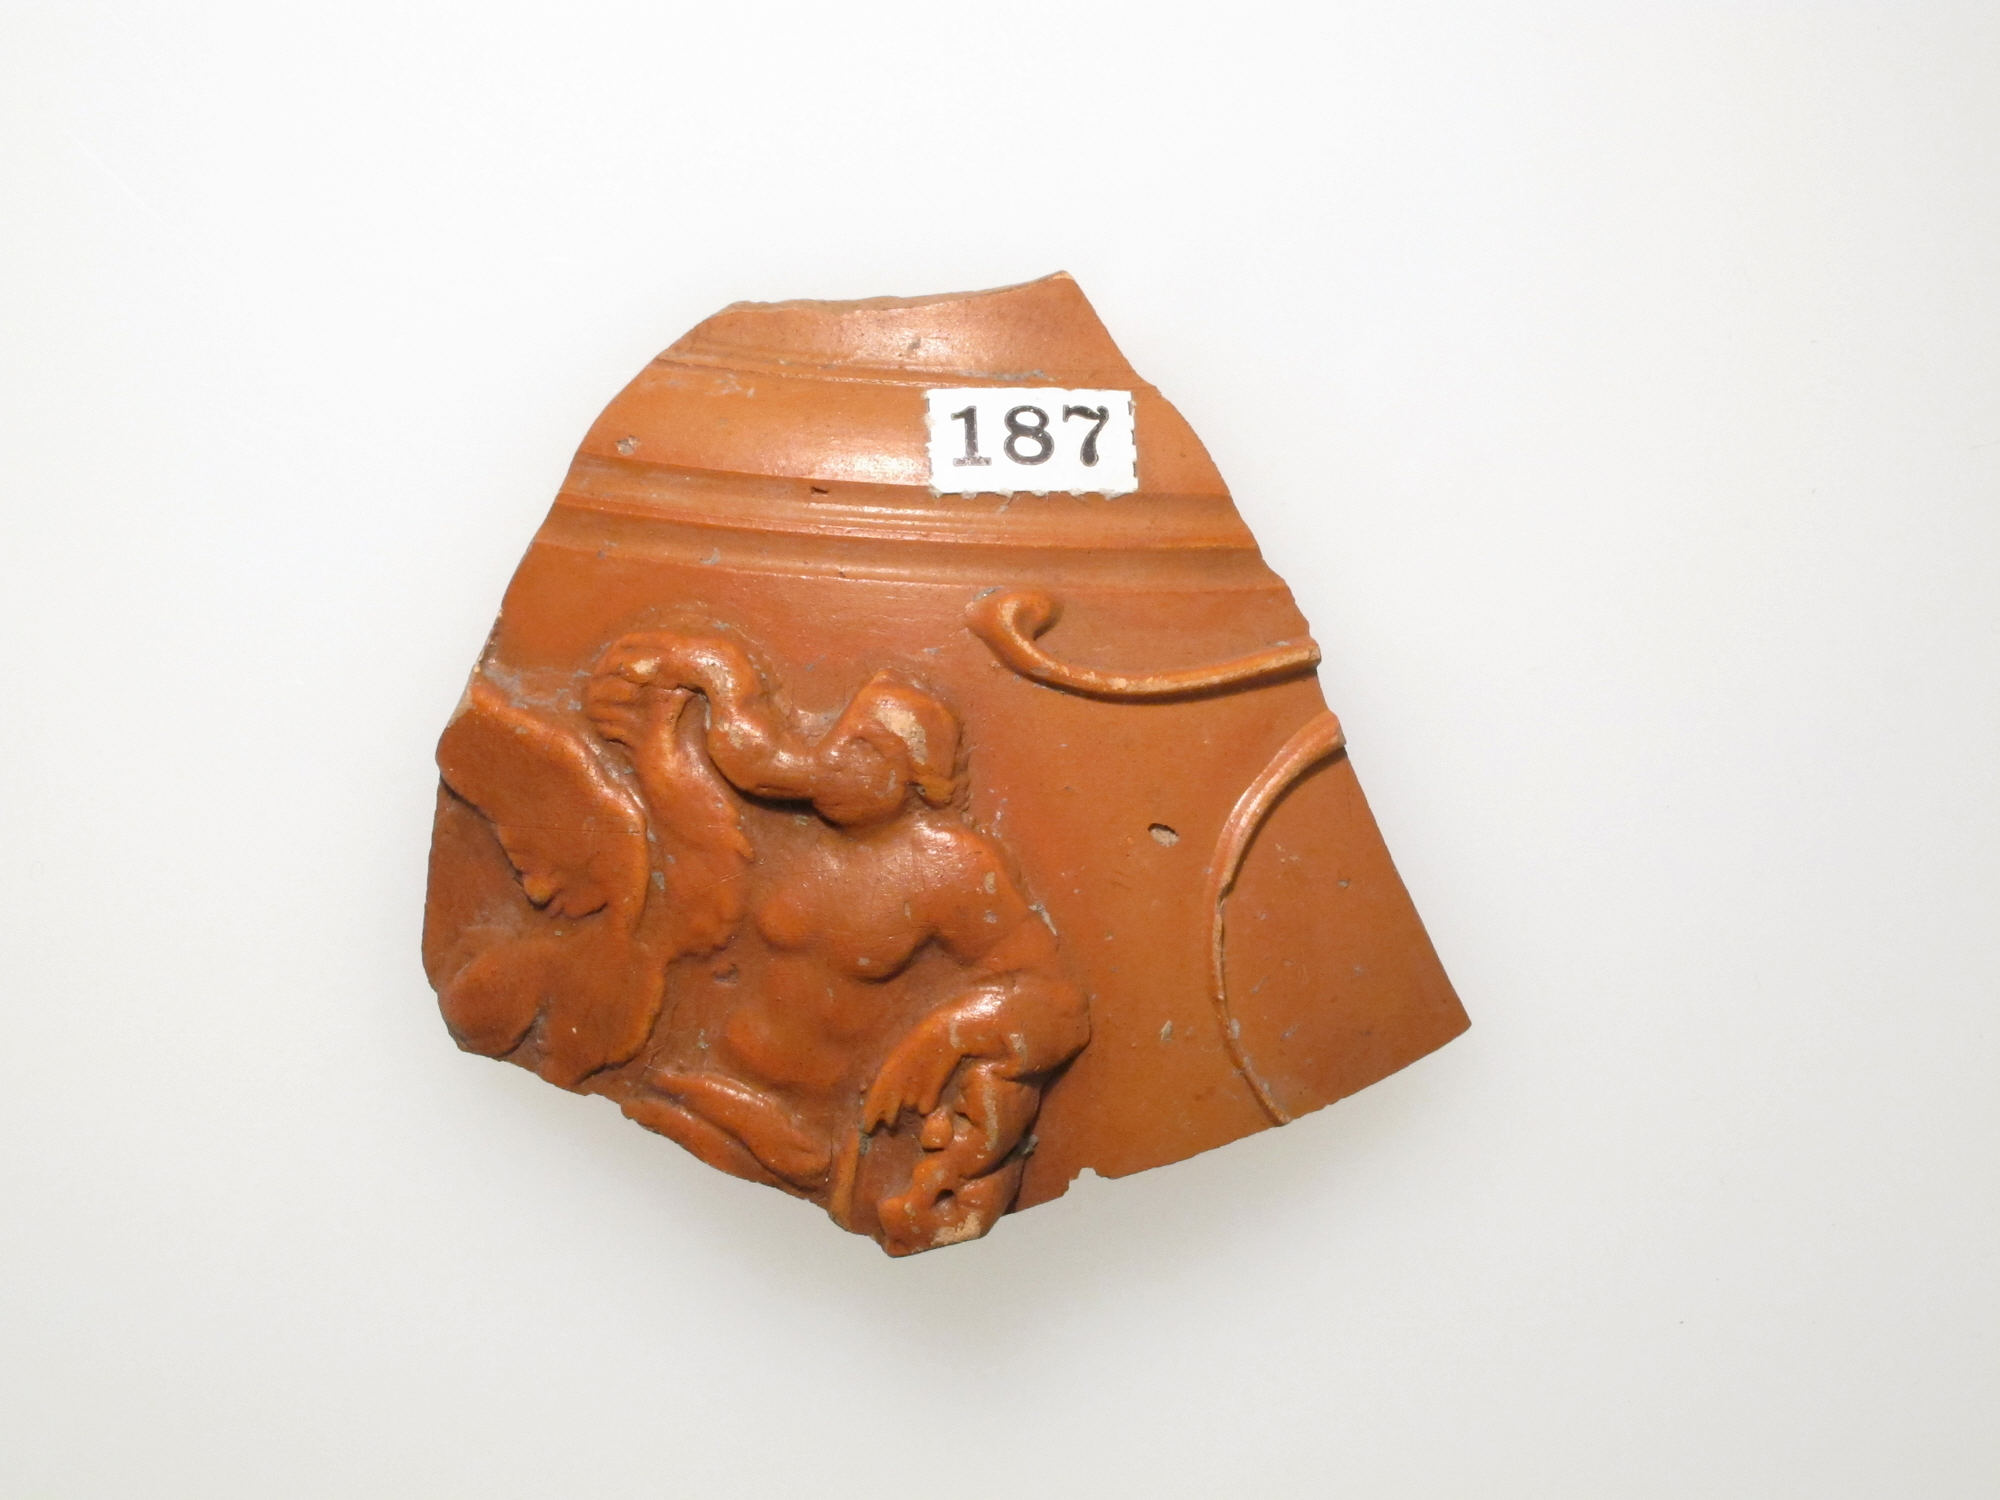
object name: vase fragment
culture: roman, gaul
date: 120 BCE-300 CE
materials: terracotta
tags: men